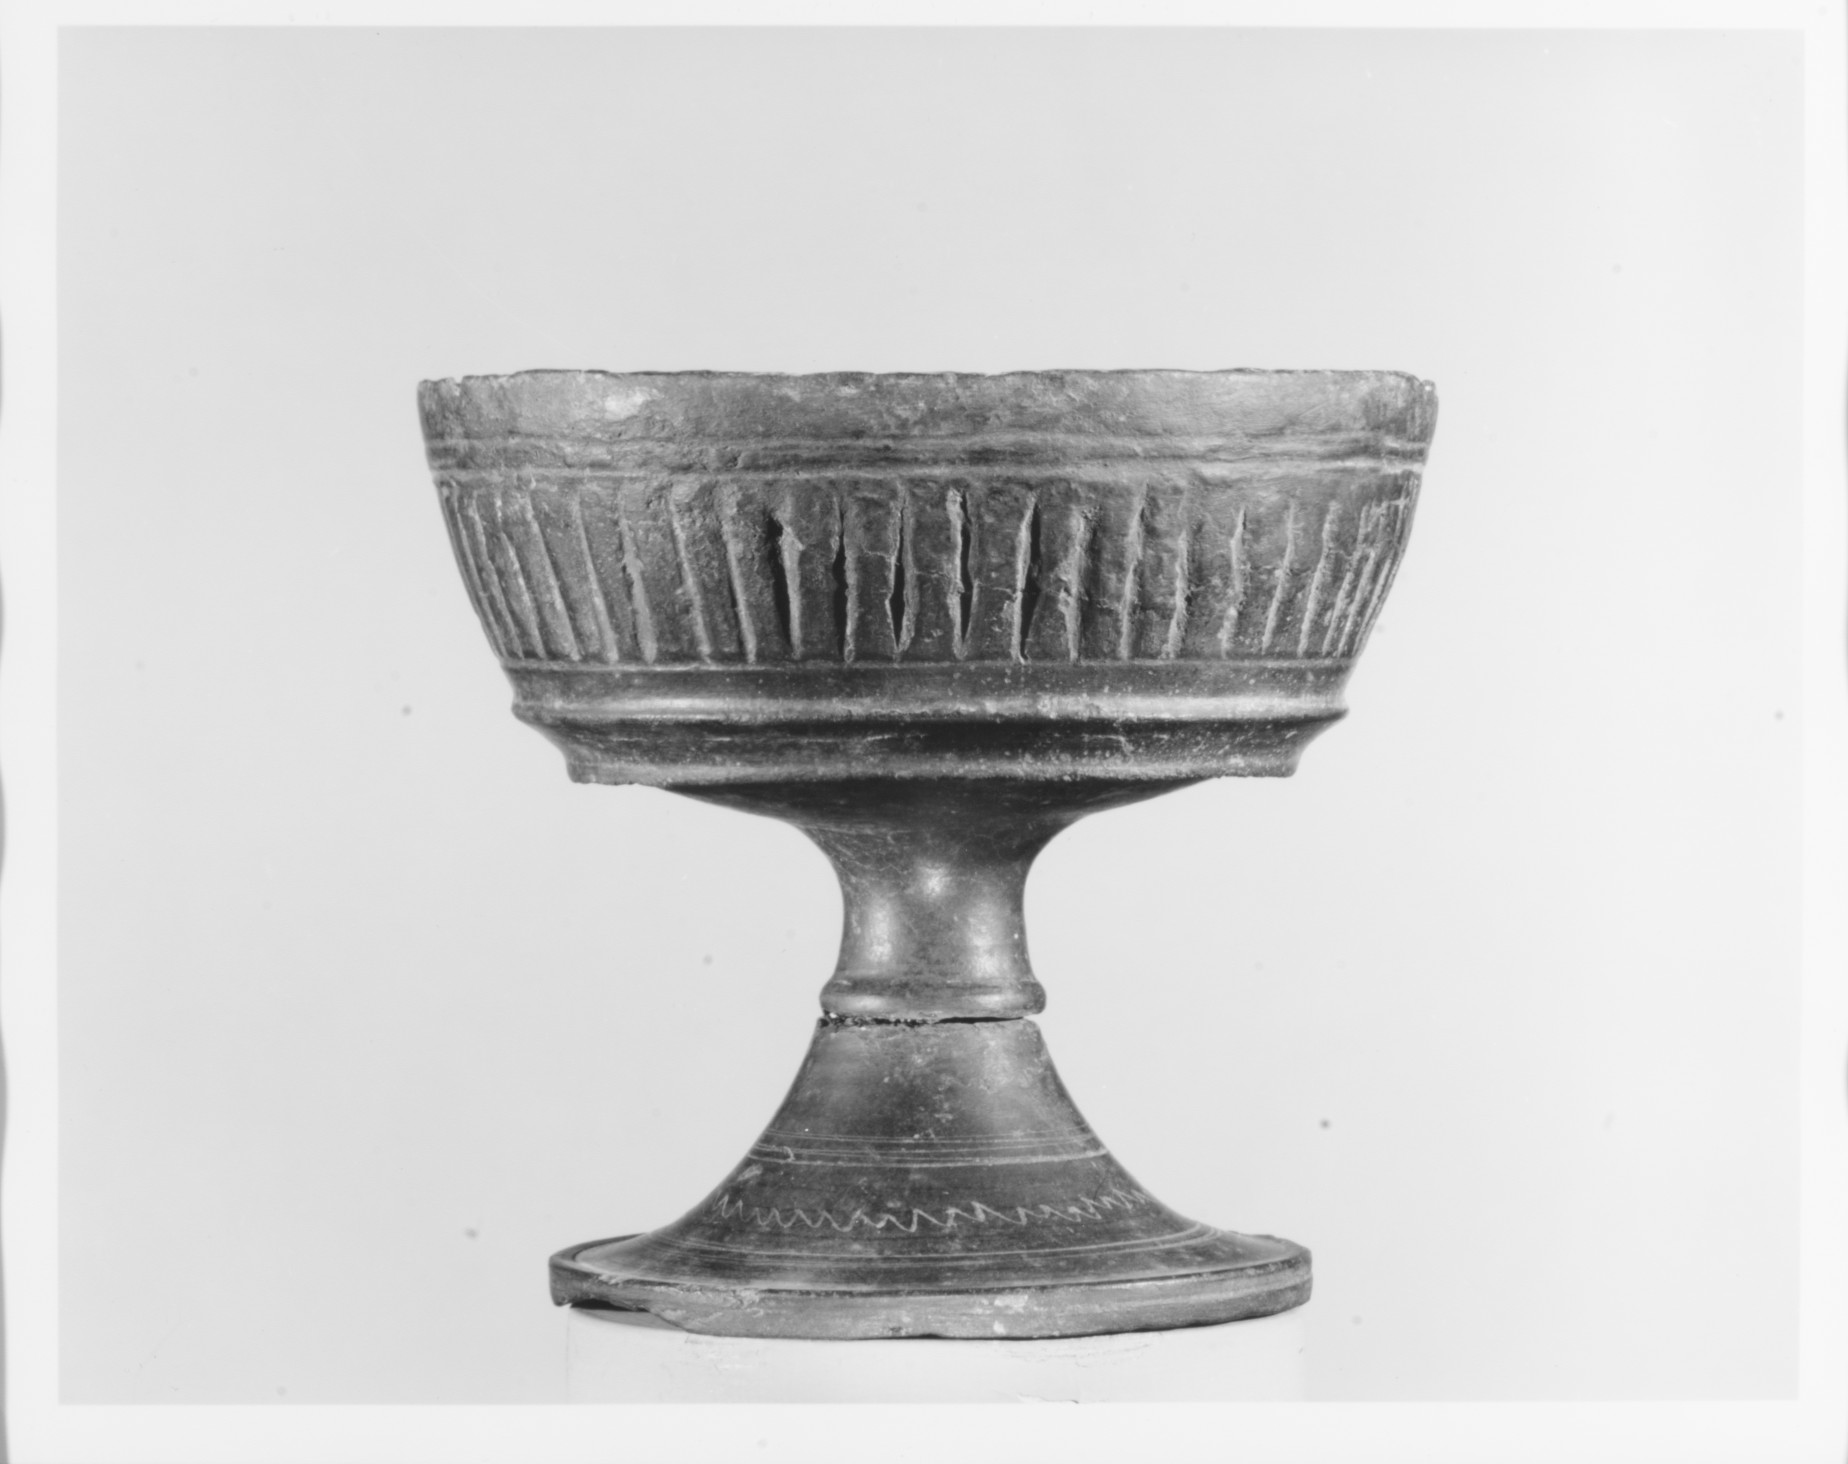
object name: cup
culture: etruscan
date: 600-551 BCE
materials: terracotta